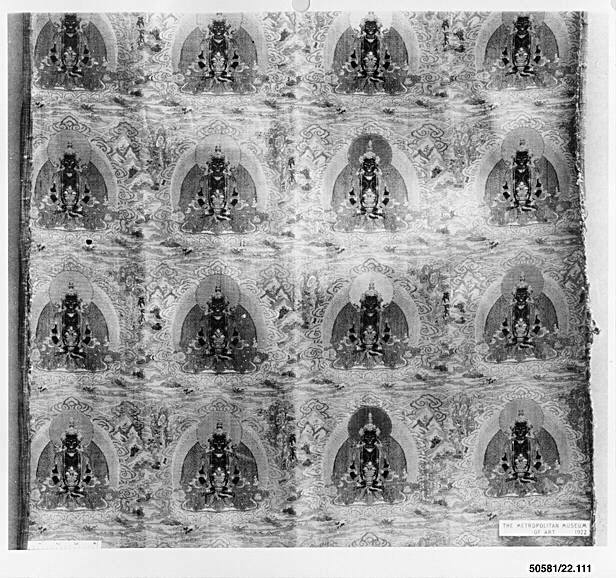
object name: panel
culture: chinese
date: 1736-1795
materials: metal thread, silk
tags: goddess